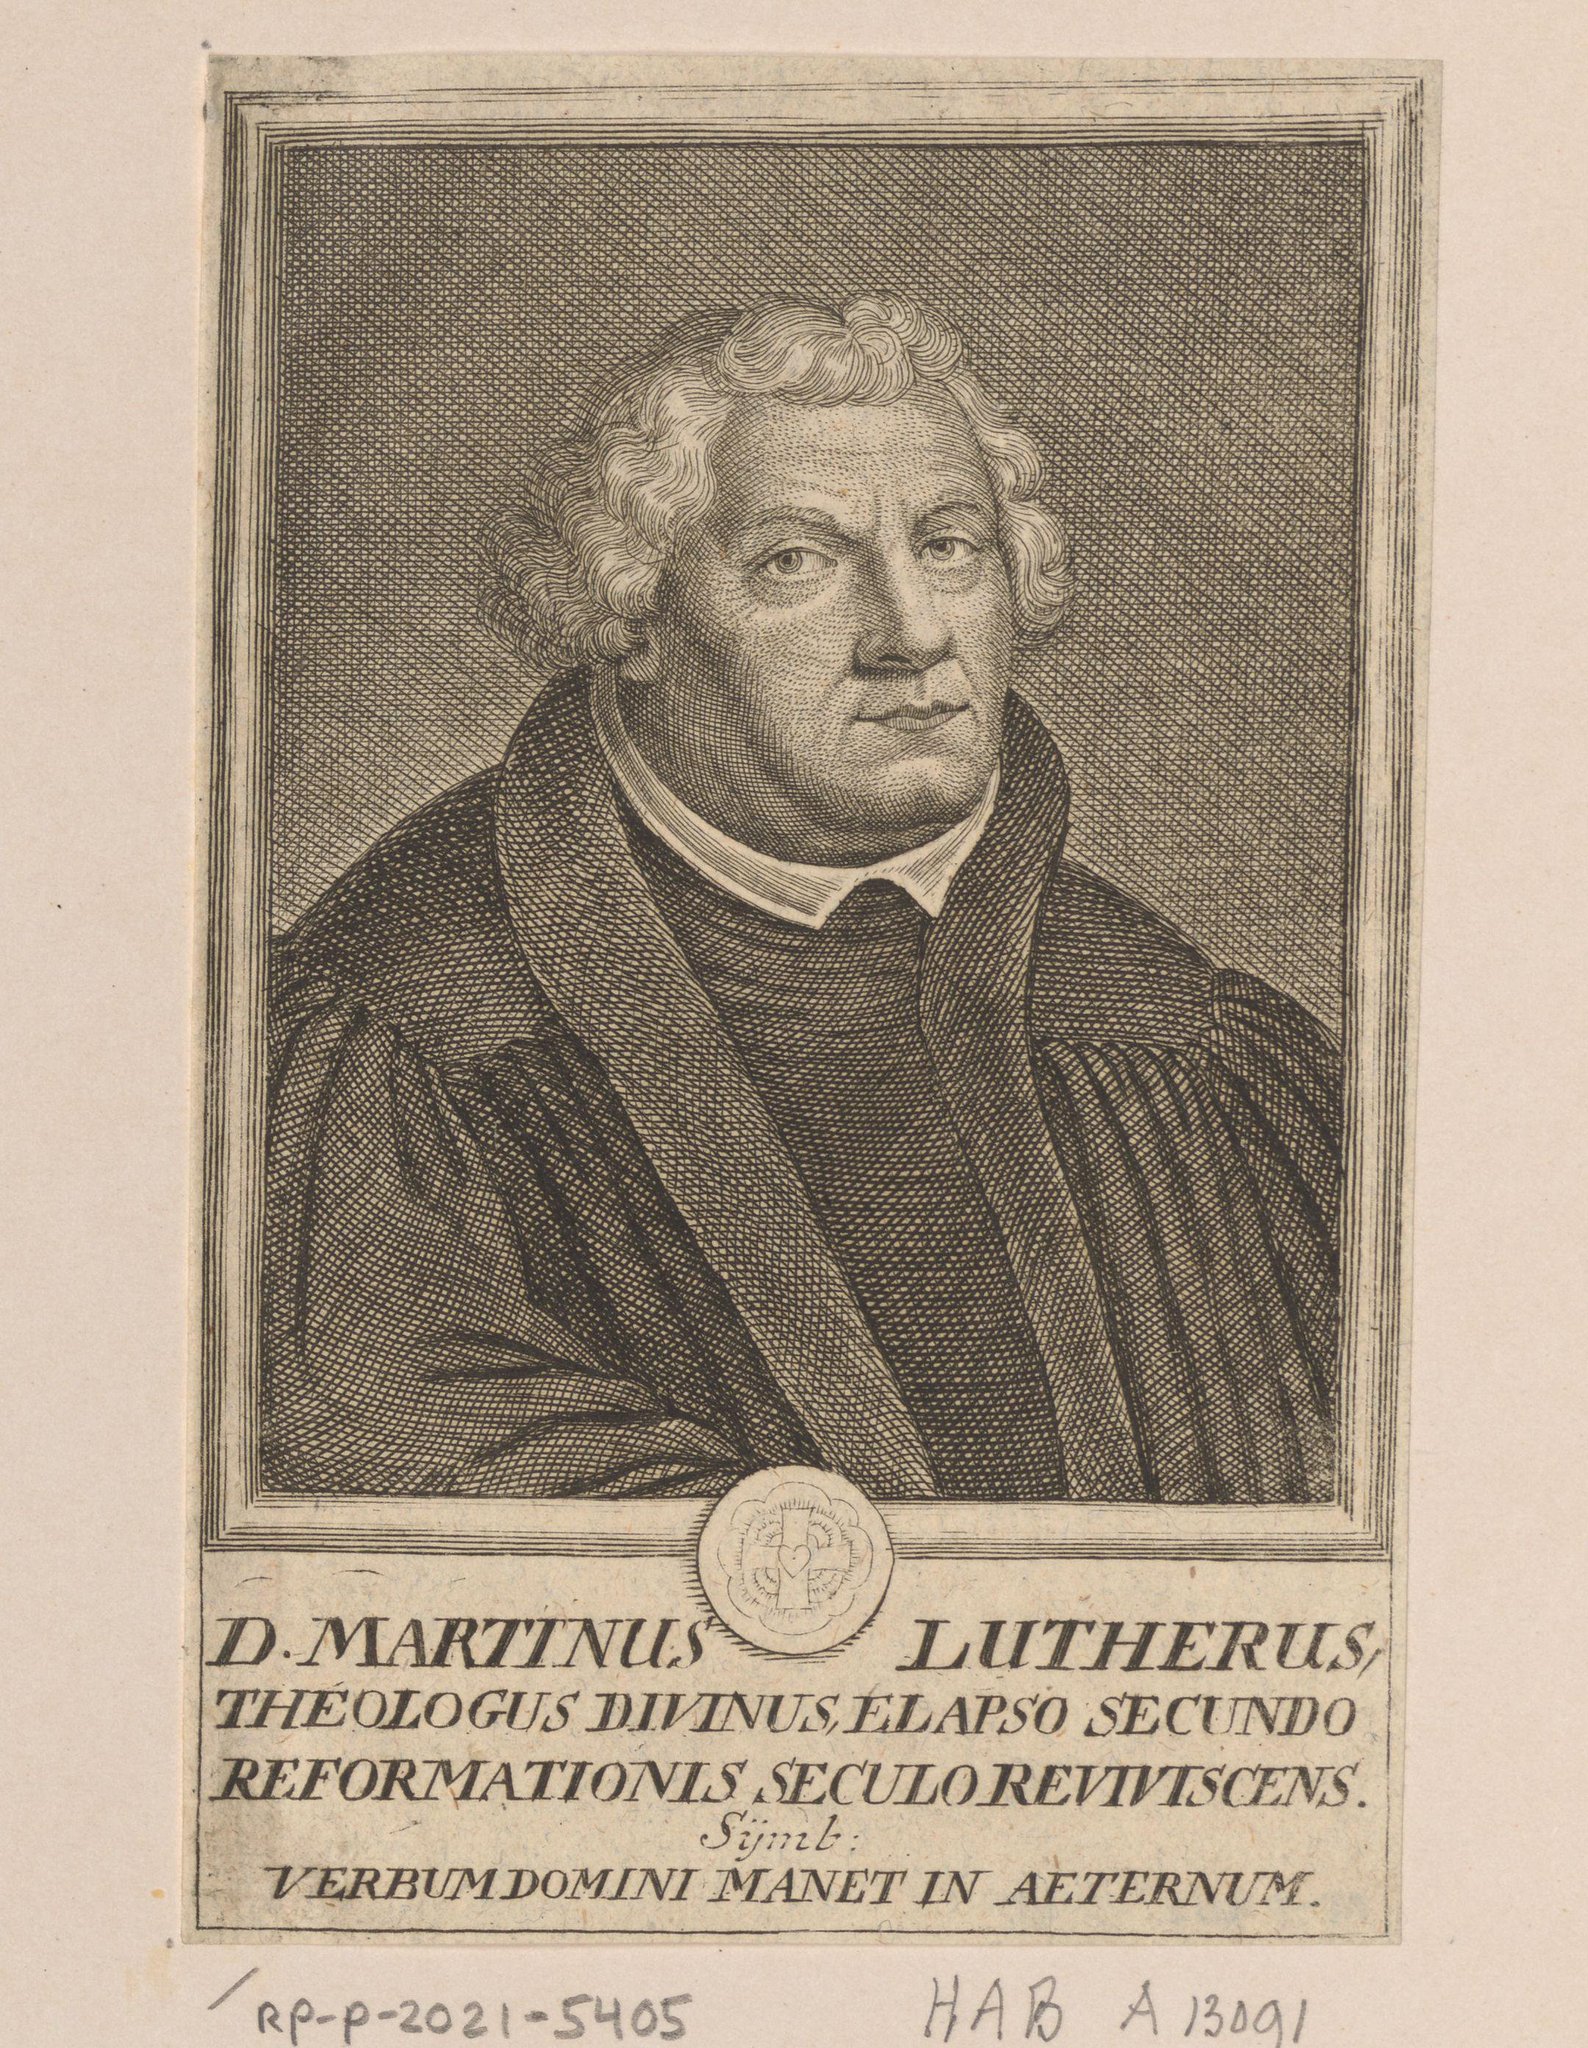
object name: print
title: Portret van Martin Luther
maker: Anonymous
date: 1718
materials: paper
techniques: engraving, etching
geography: germany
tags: priest, martin luther, theologian, historical persons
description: Prent waarschijnlijk uit: Fleuter, Johann Basilius. Historischer Catechismus von der Reformation Lutheri (...). Wittenberg: Christian Gottlieb Ludwig, 1718.